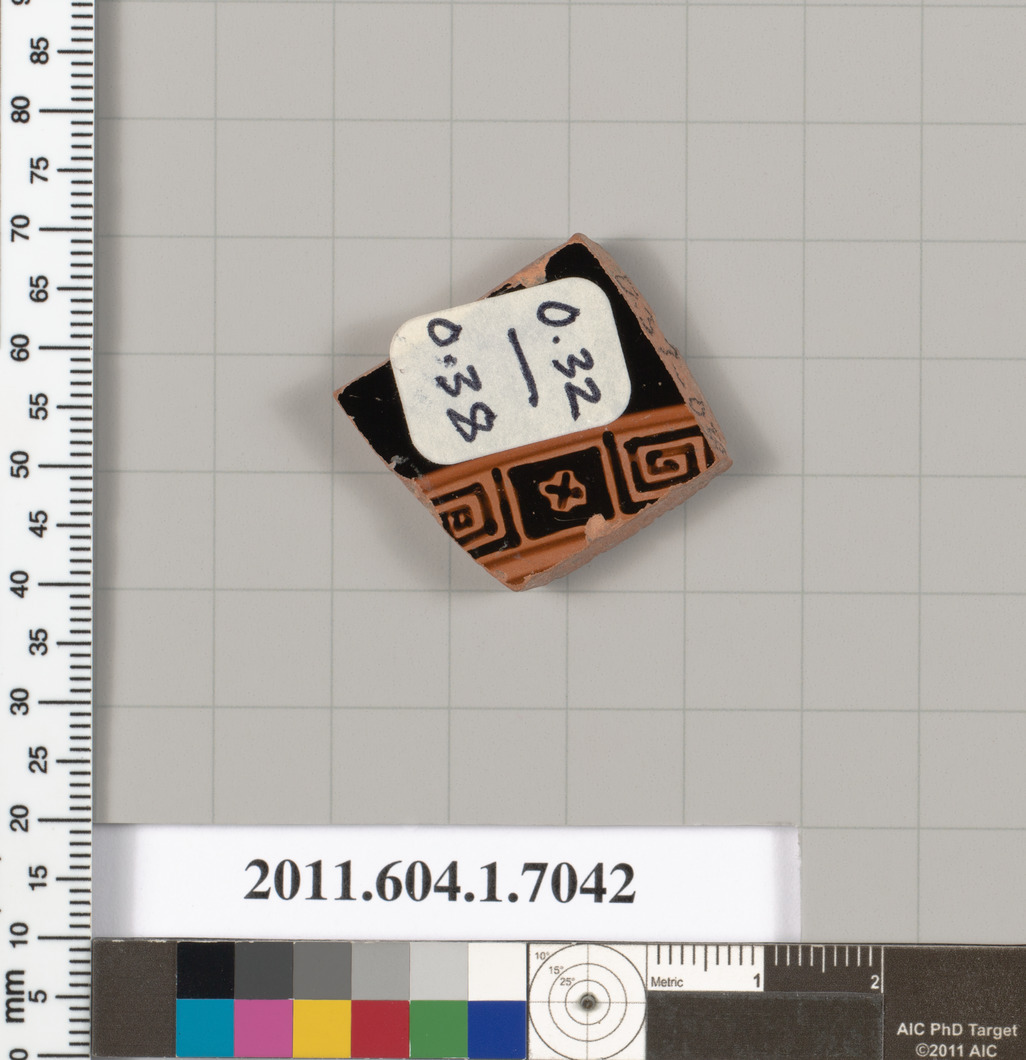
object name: kylix fragment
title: Terracotta fragment of a kylix (drinking cup)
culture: greek, attic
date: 500-480 BCE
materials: terracotta